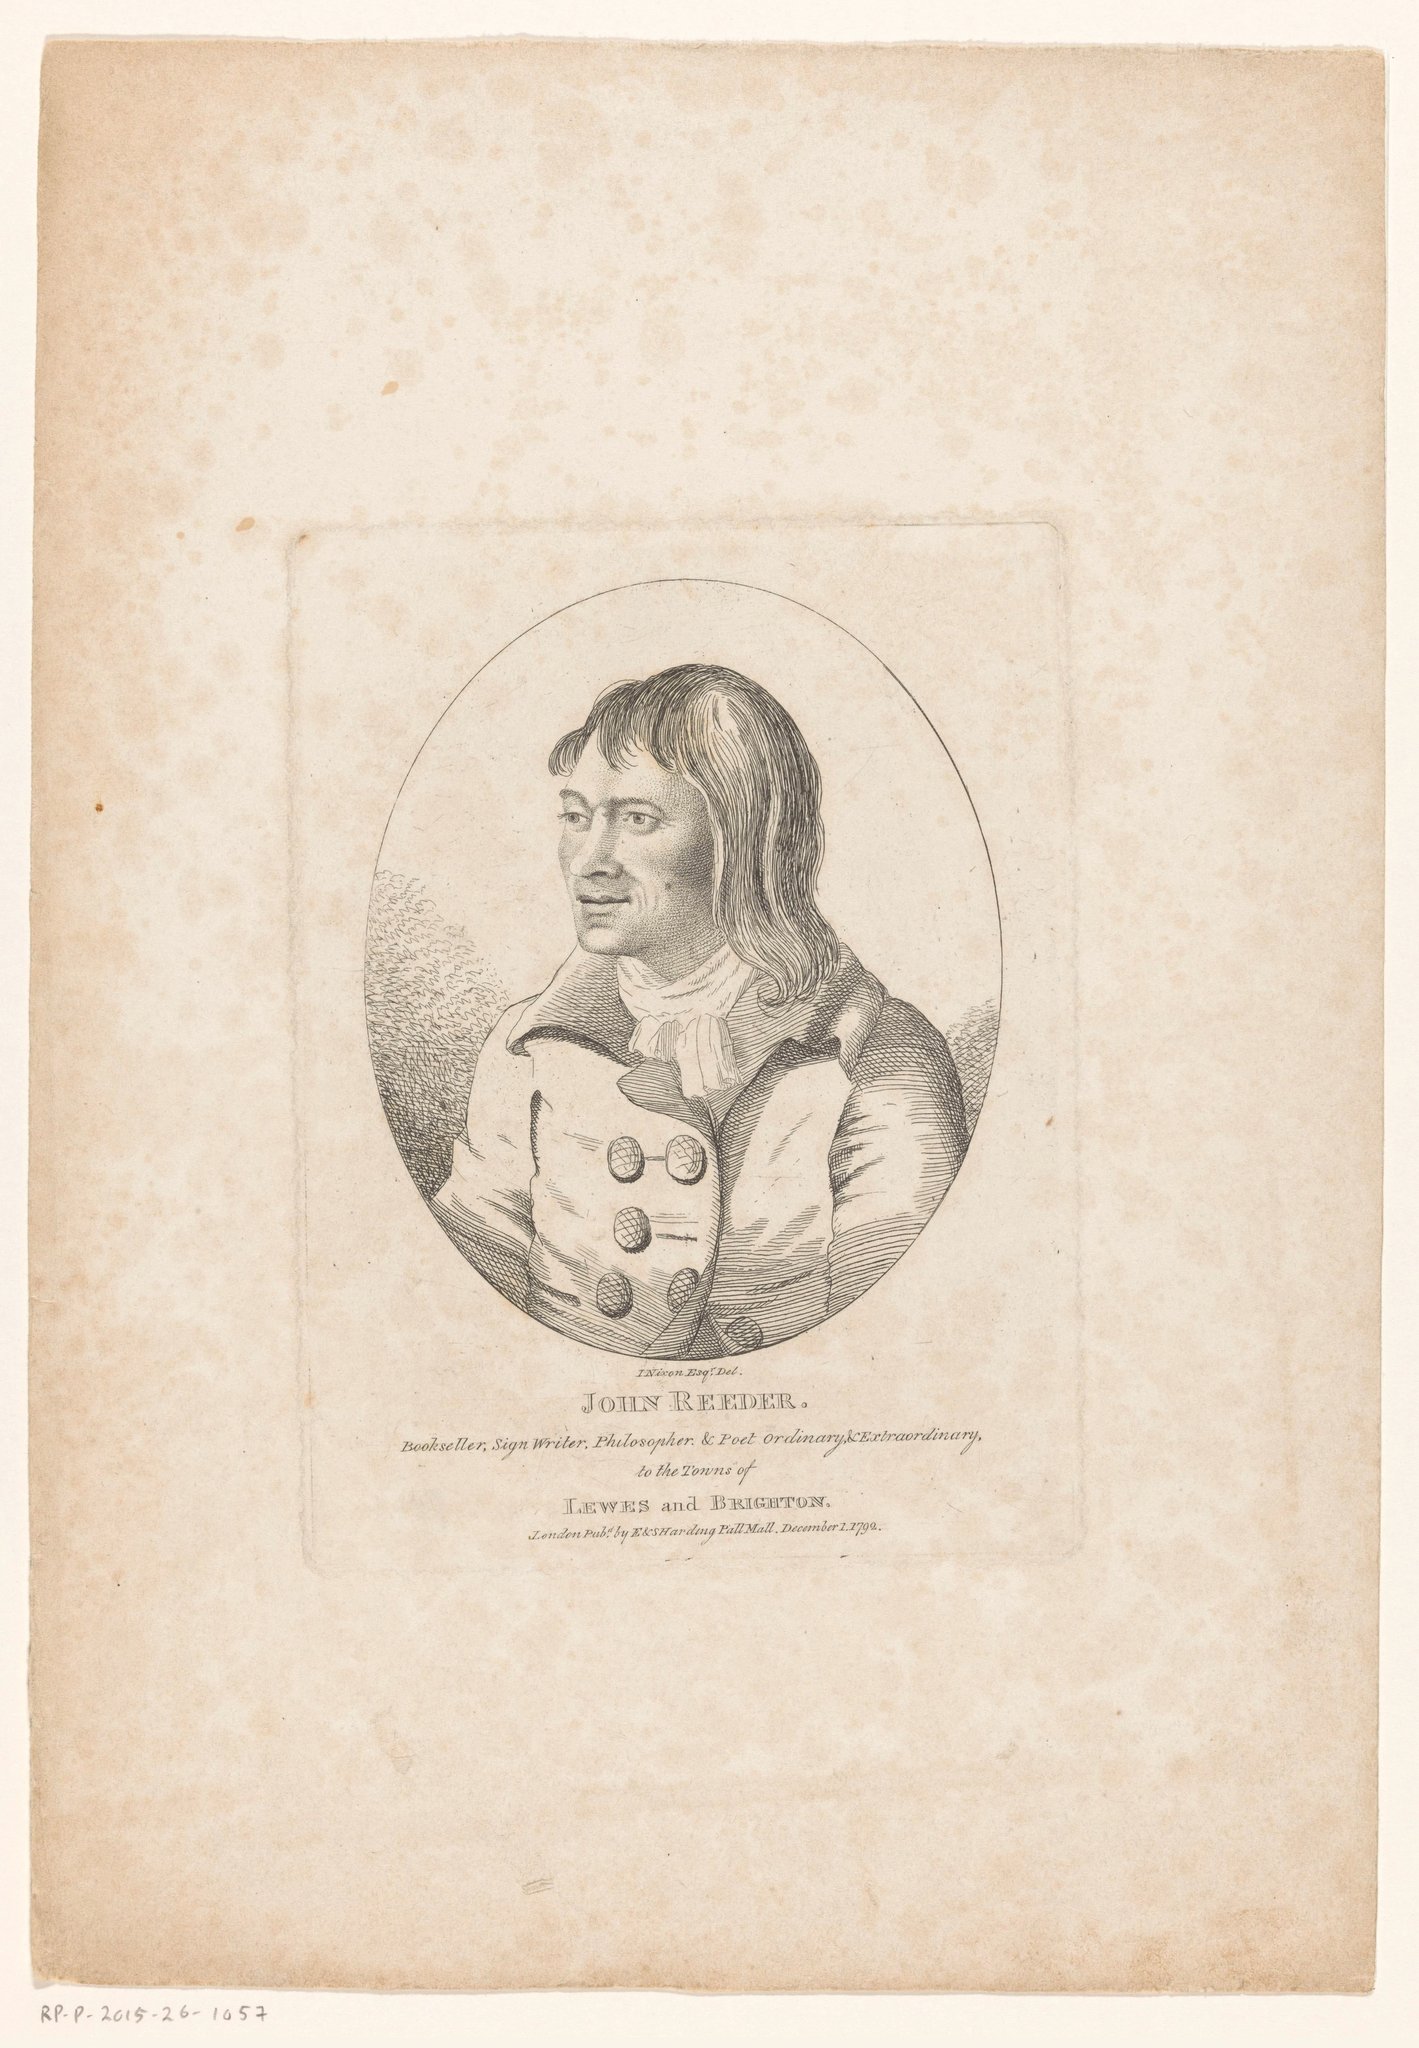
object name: print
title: John Reeder. bookseller, sign writer ((...)) of Lewes and Brighton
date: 1712-1792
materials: paper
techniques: etching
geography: london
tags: bookseller, book-shop, bookseller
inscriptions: collector's mark: Lugt 2228, collector's mark: Lugt 4779